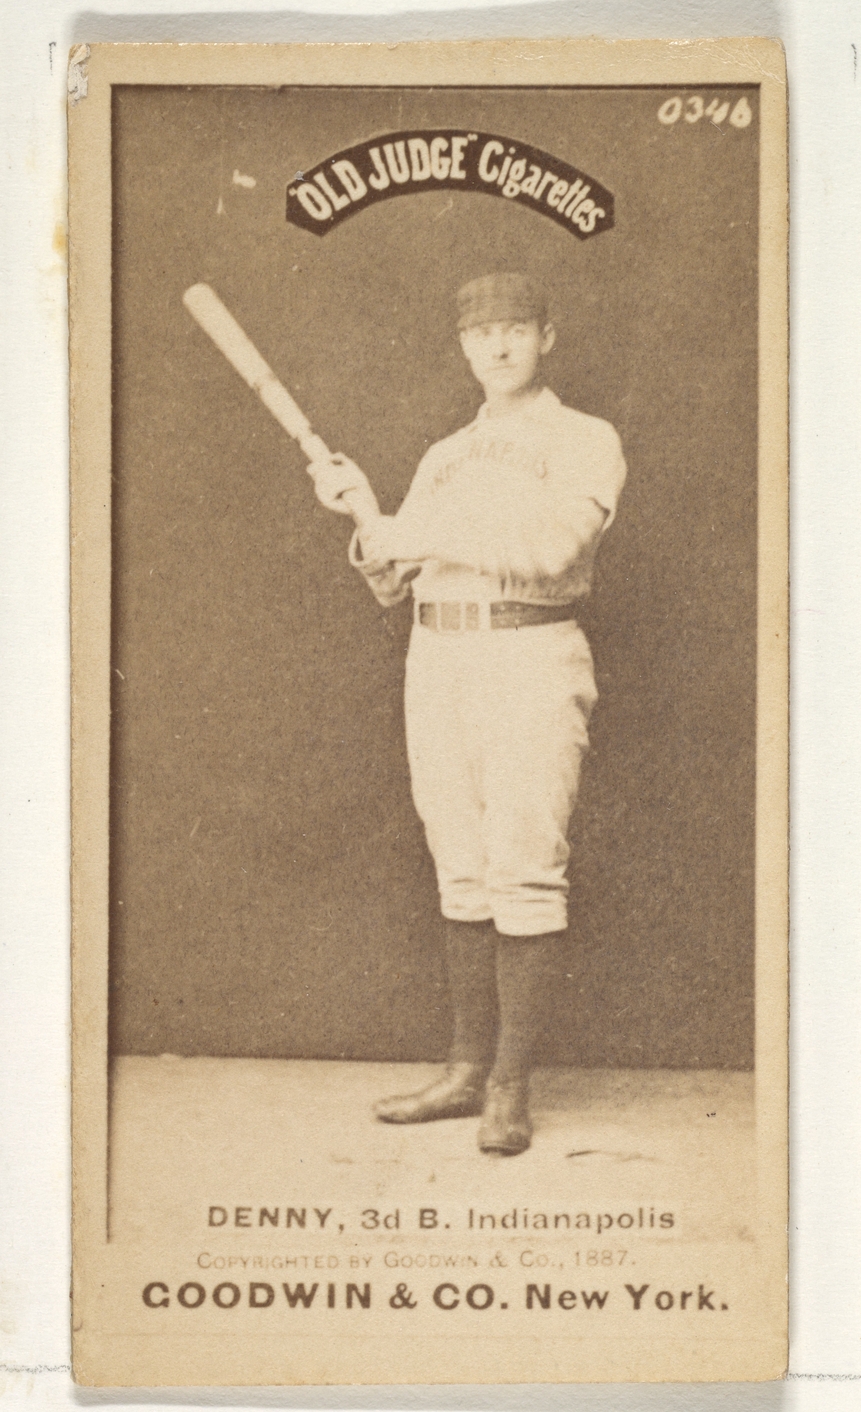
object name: baseball card, photograph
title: Jerry Denny, 3rd Base, Indianapolis, from the Old Judge series (N172) for Old Judge Cigarettes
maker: goodwin & company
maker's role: publisher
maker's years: 1850-1950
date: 1887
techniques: albumen silver print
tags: men,portraits,baseball,athletes